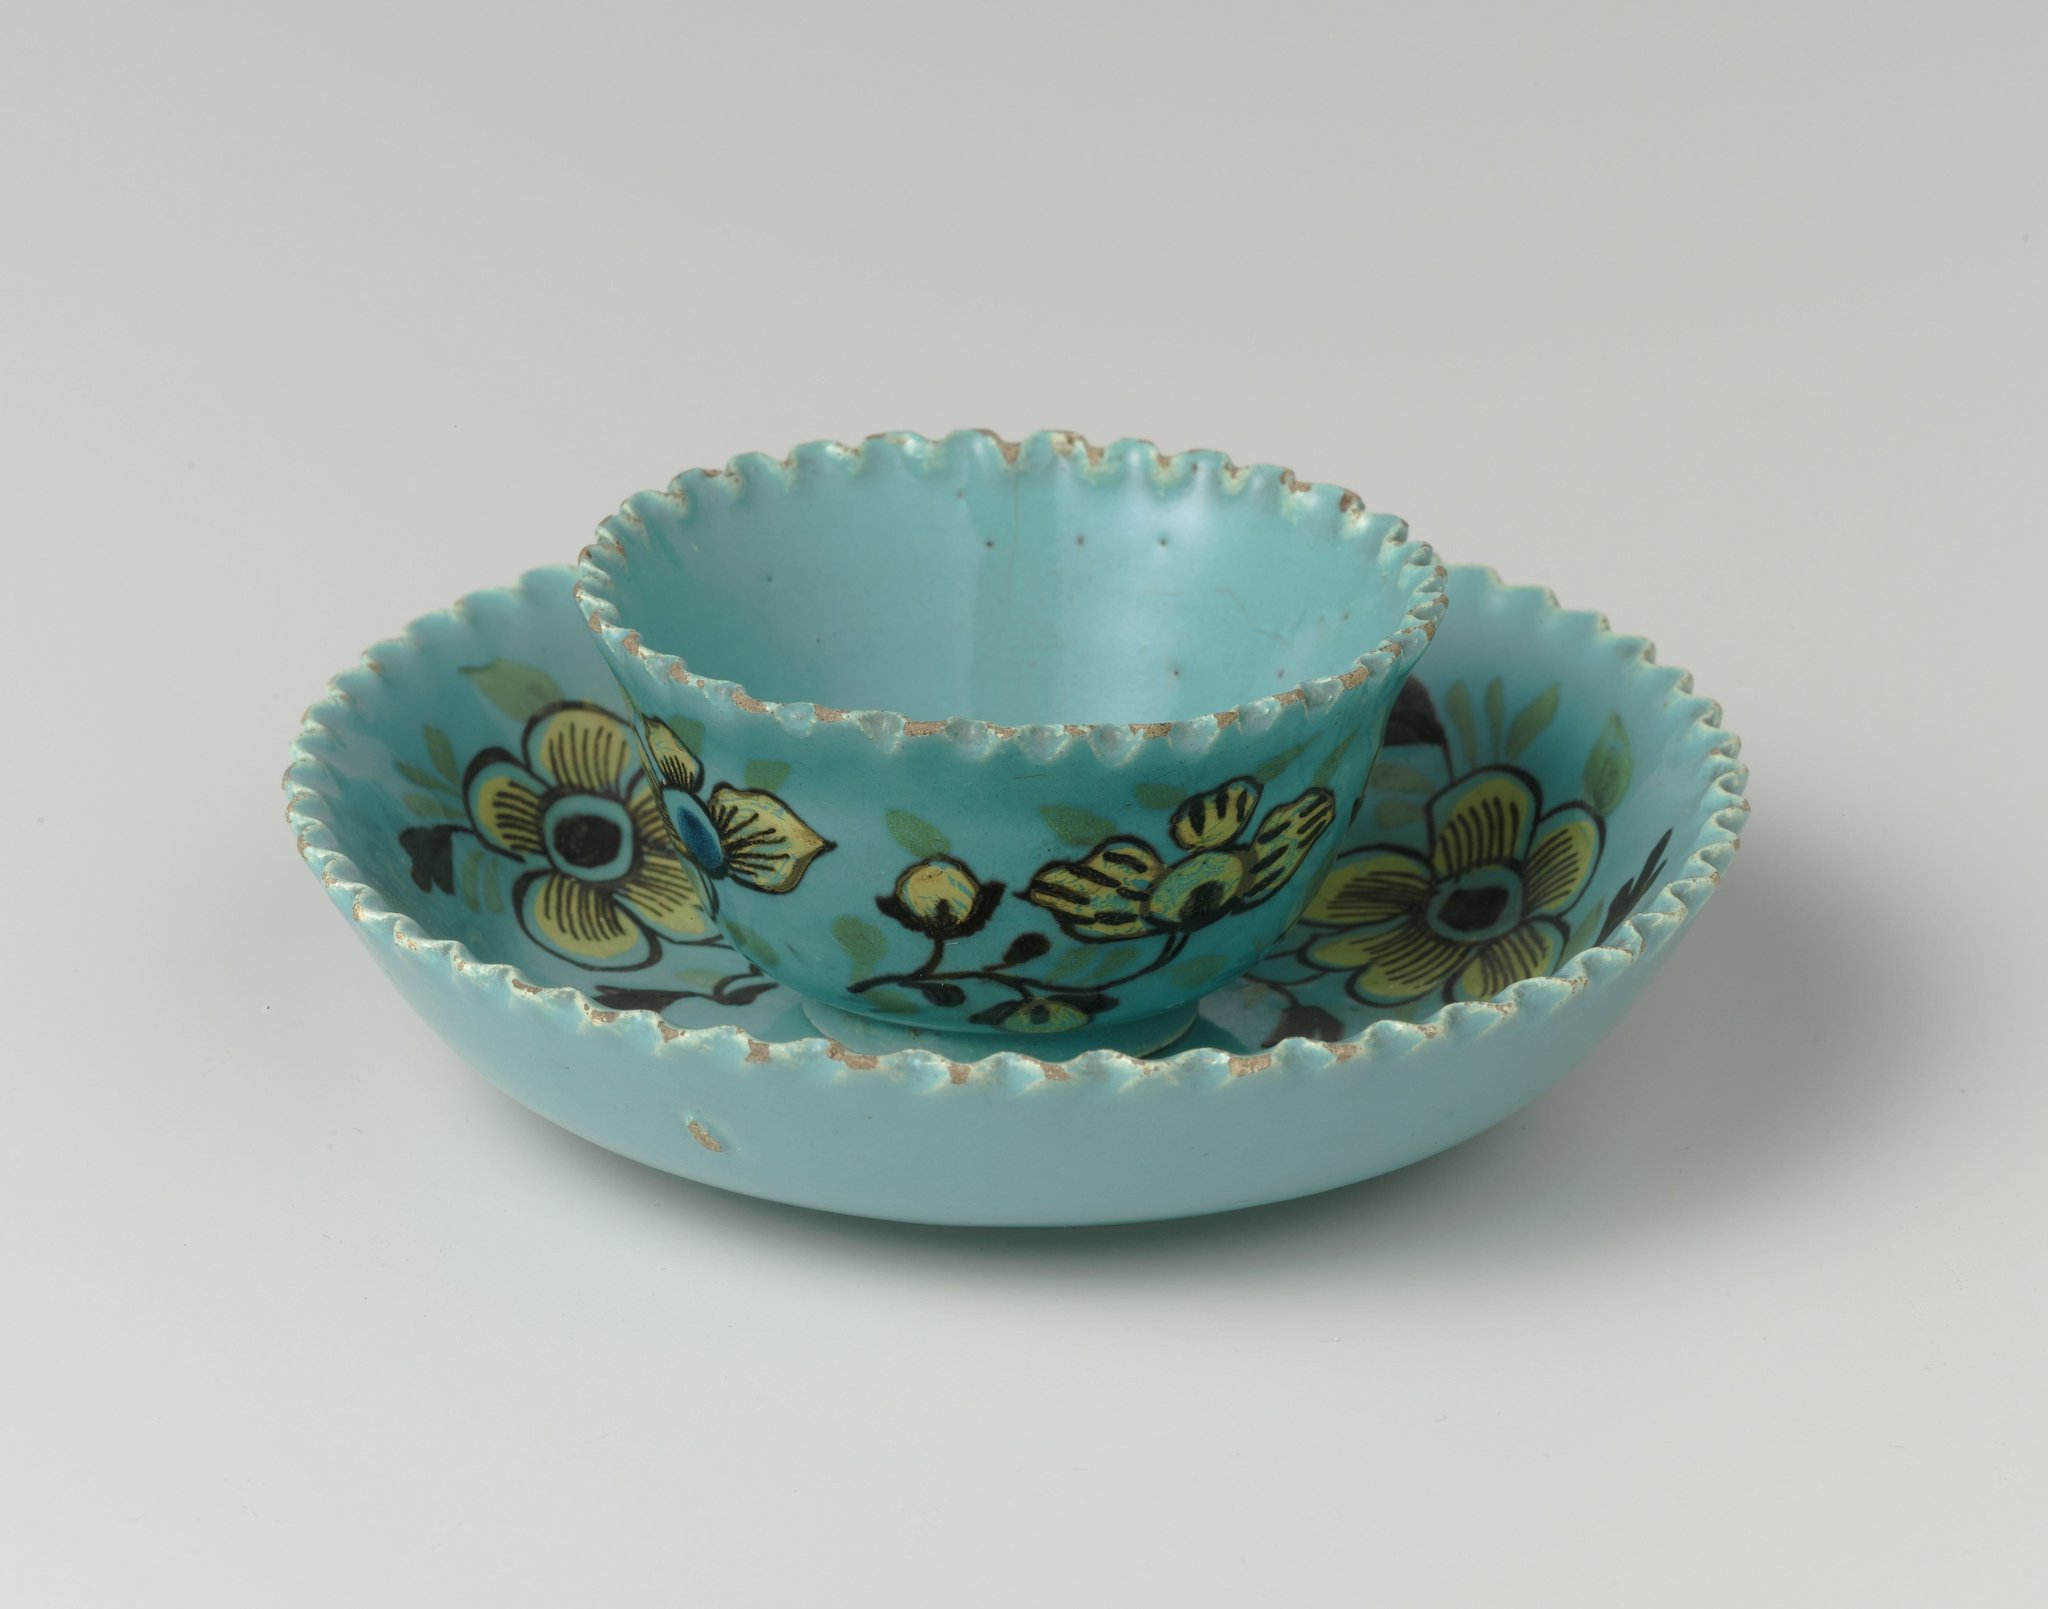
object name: kop en schotel, kop en schotel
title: Schotel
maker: Anonymous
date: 1720-1750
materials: earthenware, glaze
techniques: painted, polychromy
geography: delft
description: Schotel van veelkleurig beschilderde faience. De kop en schotel zijn beschilderd met gele bloemen op een turkooizen achtergrond. De randen van de schotel zijn gekarteld.